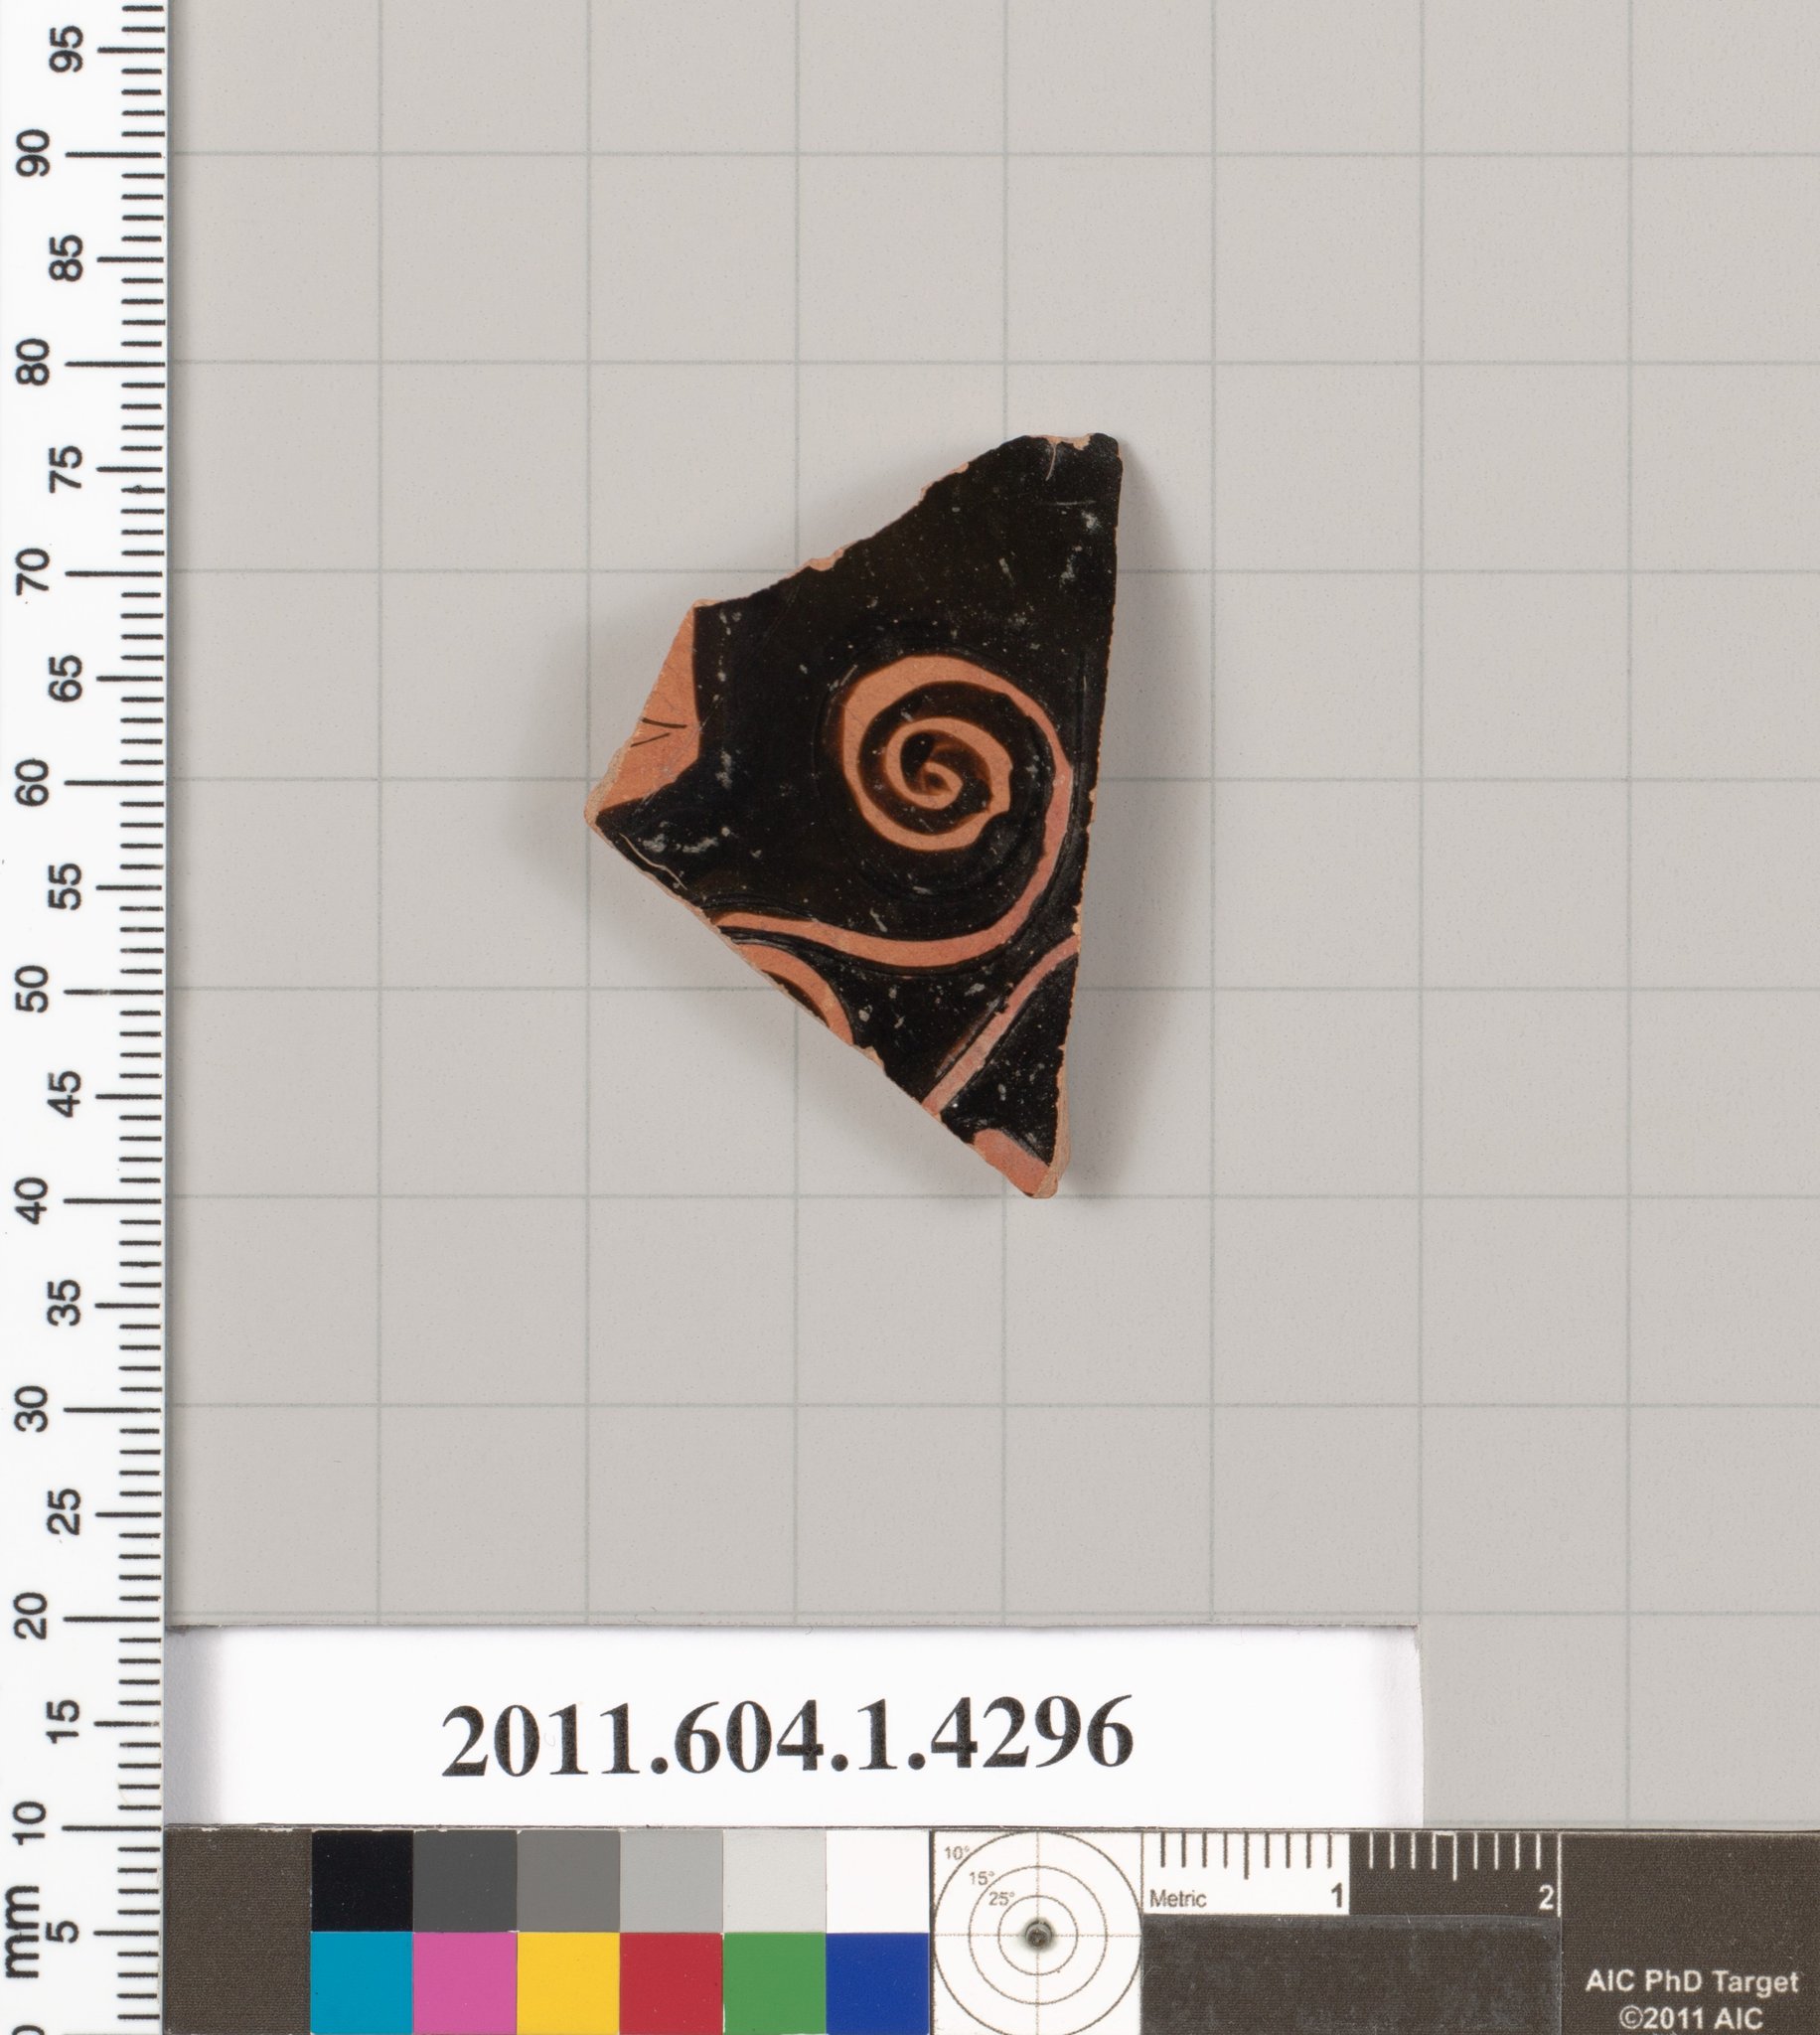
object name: kylix fragment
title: Terracotta fragment of a kylix (drinking cup)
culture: greek, attic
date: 475-451 BCE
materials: terracotta